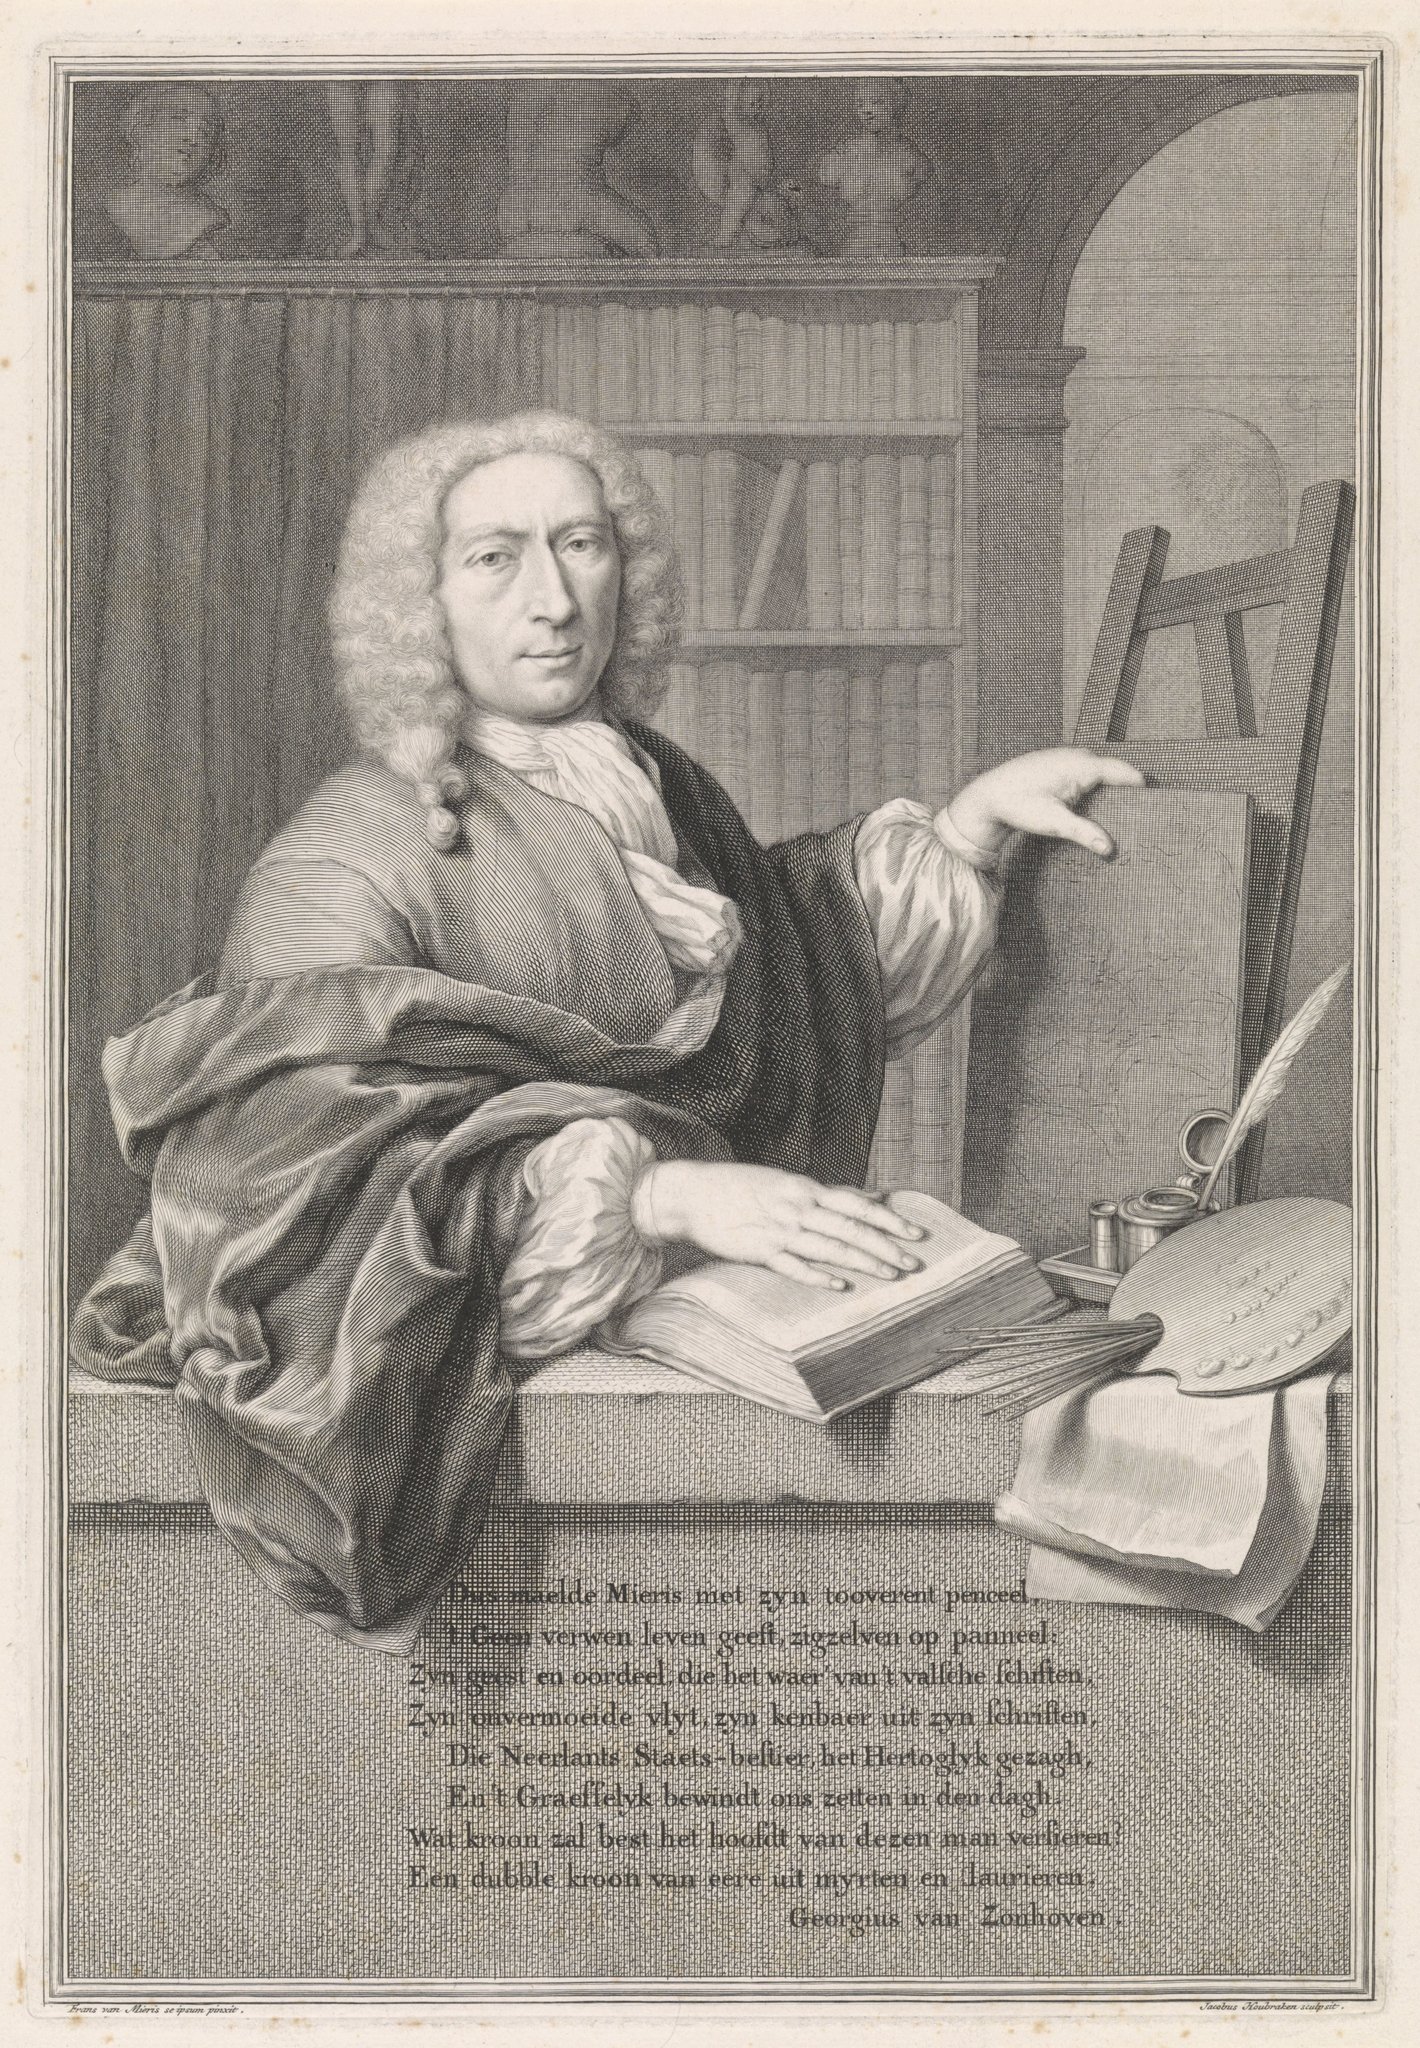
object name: print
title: Portret van Frans van Mieris (II)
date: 1708-1780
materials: paper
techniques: engraving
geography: amsterdam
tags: leiden, painter, print maker, draughtsman, frans van mieris (ii), portrait, self-portrait of painter, tools, implements of painter, easel, artist at work, in his workshop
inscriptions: collector's mark: Lugt 2228, collector's mark: Lugt 240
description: Frans van Mieris (II) in een interieur van een atelier. Met zijn linkerhand houdt hij een schilderij vast op een ezel. Voor hem een plint waarop een opengeslagen boek, schildersattributen en schrijfgerei. Op de achtergrond een boekenkast waarop enkele beelden. Onder het portret een achtregelig vers in het Nederlands.